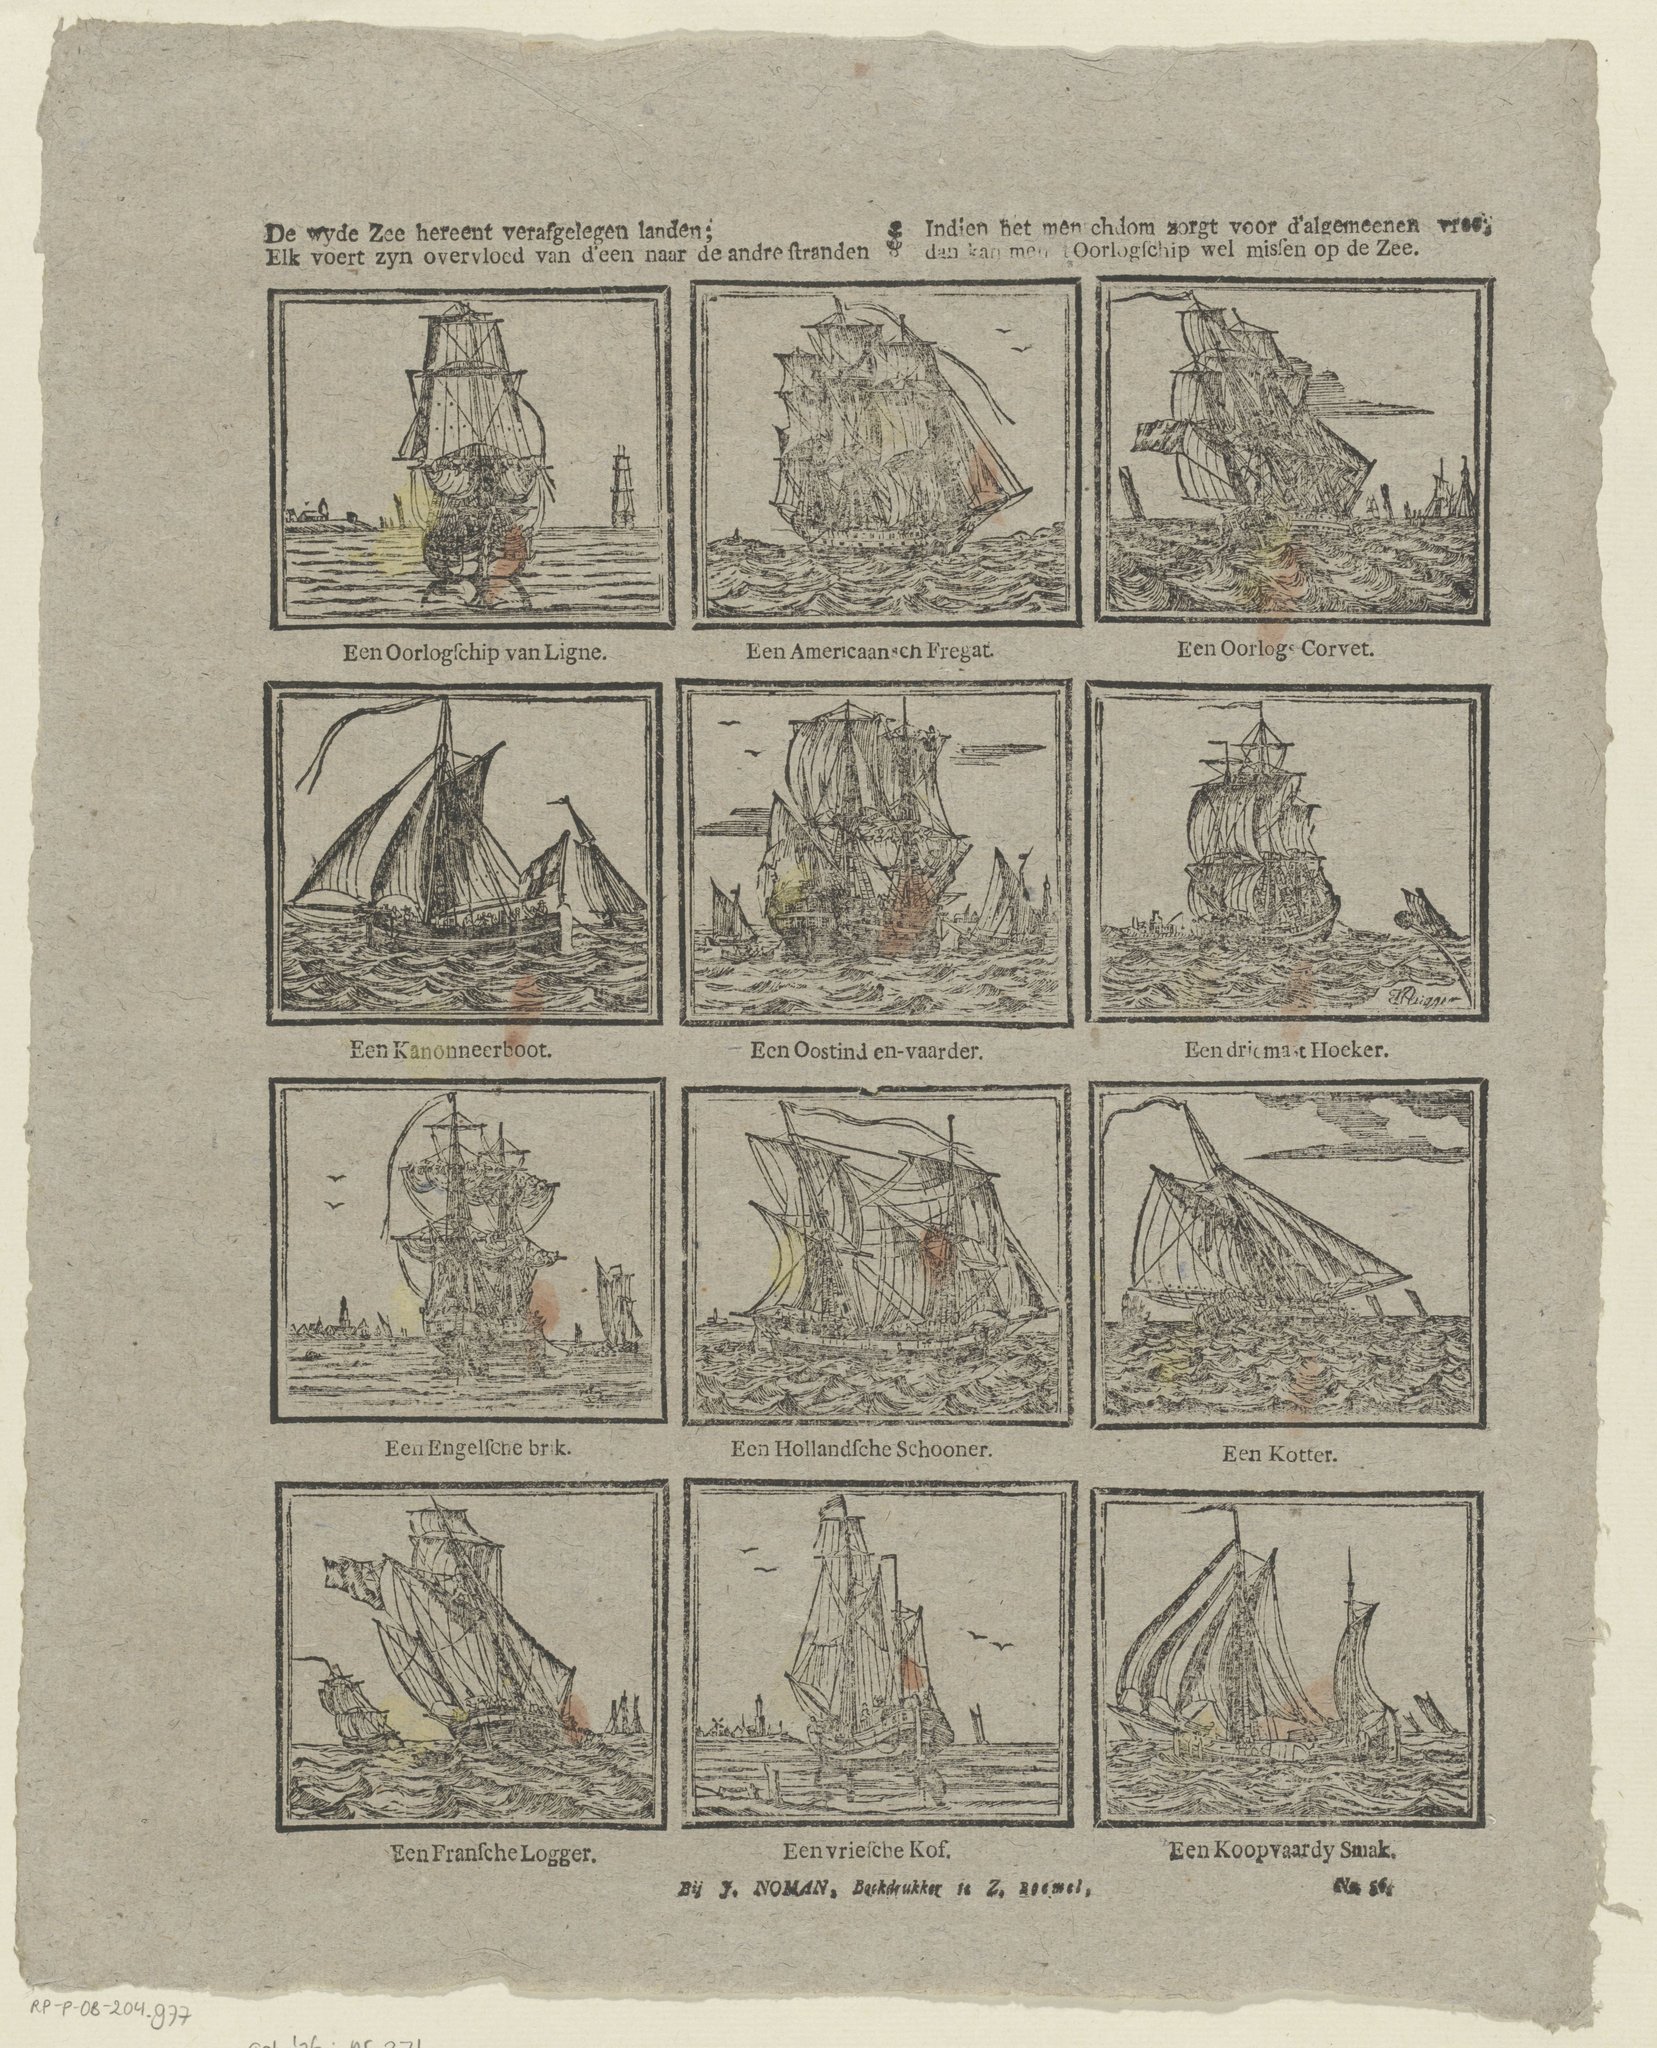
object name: popular print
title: De wyde zee hereent verafgelegen landen; / Elk voert zyn overvloed van d'een naar de andre stranden. / Indien het menschdom zorgt voor d'algemeenen vree, / dan kan men 't oorlogsschip wel missen op de zee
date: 1806-1830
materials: paper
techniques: colour, letterpress printing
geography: netherlands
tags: military vehicles (+ sailing-ships), ships (in general)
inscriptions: collector's mark: Lugt 2760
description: Blad met 12 voorstellingen van zeilschepen. Onder elke afbeelding een onderschrift. Genummerd rechtsonder: No. 56.